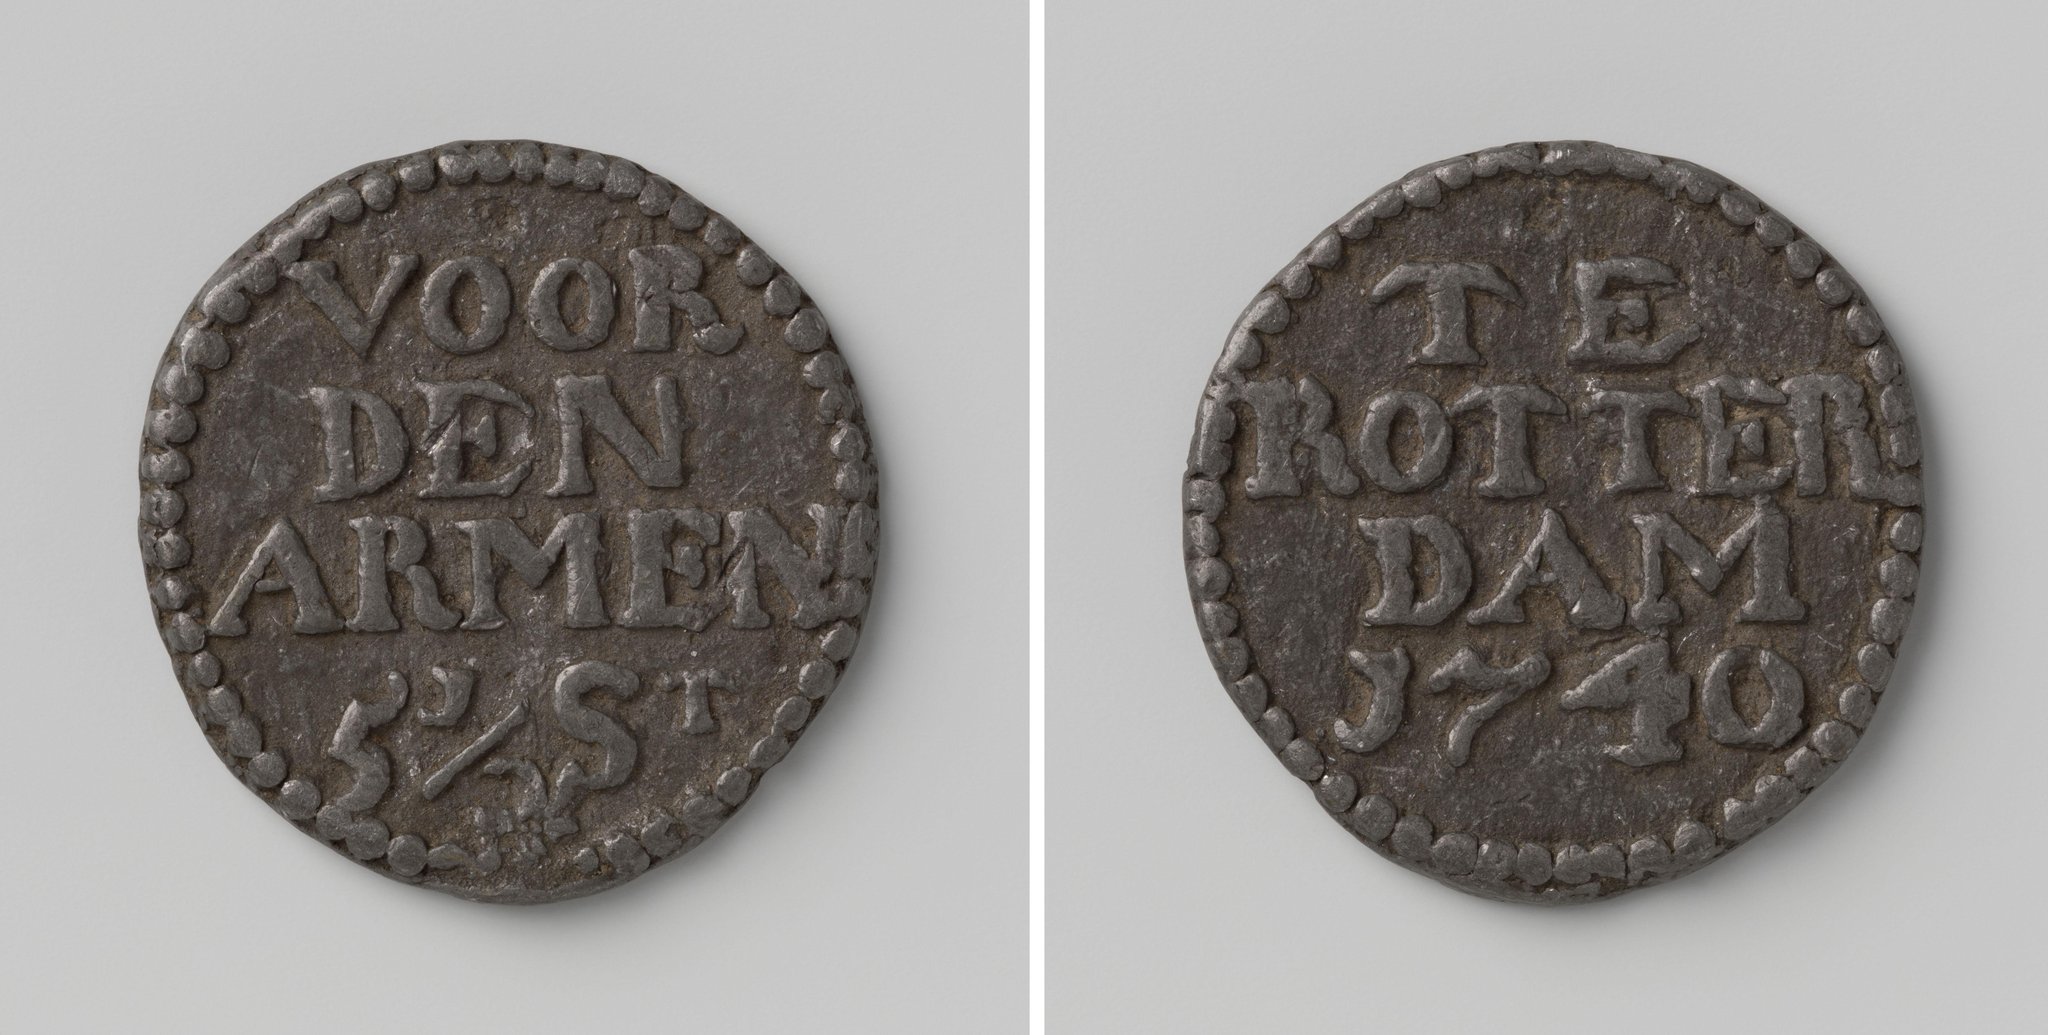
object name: armenloodje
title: Stad Rotterdam, loodje ter waarde van 5½ stuiver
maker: Anonymous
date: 1740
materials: lead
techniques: casting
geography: rotterdam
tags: rotterdam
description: Loden penning. Voorzijde: opschrift binnen parelrand. Keerzijde: opschrift binnen parelrand